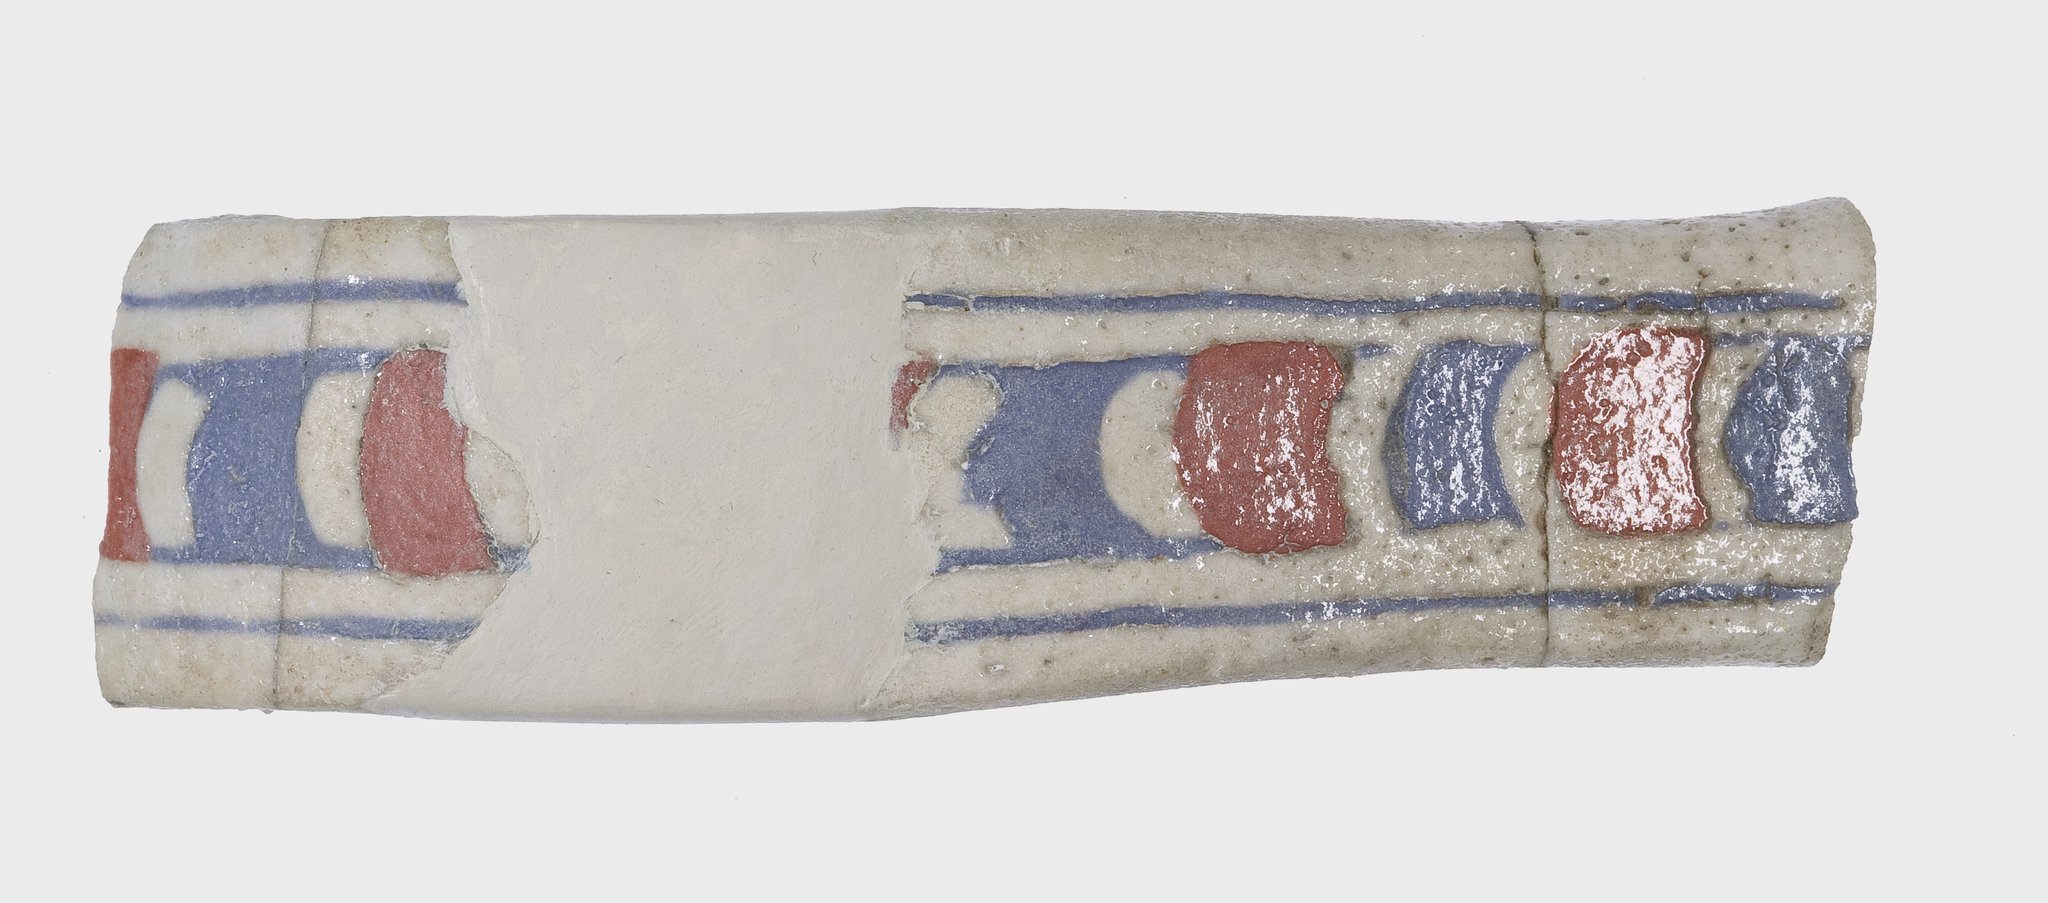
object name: vase, handle fragment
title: Part of Vase Handle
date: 1390-1352 BCE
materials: faience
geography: egypt